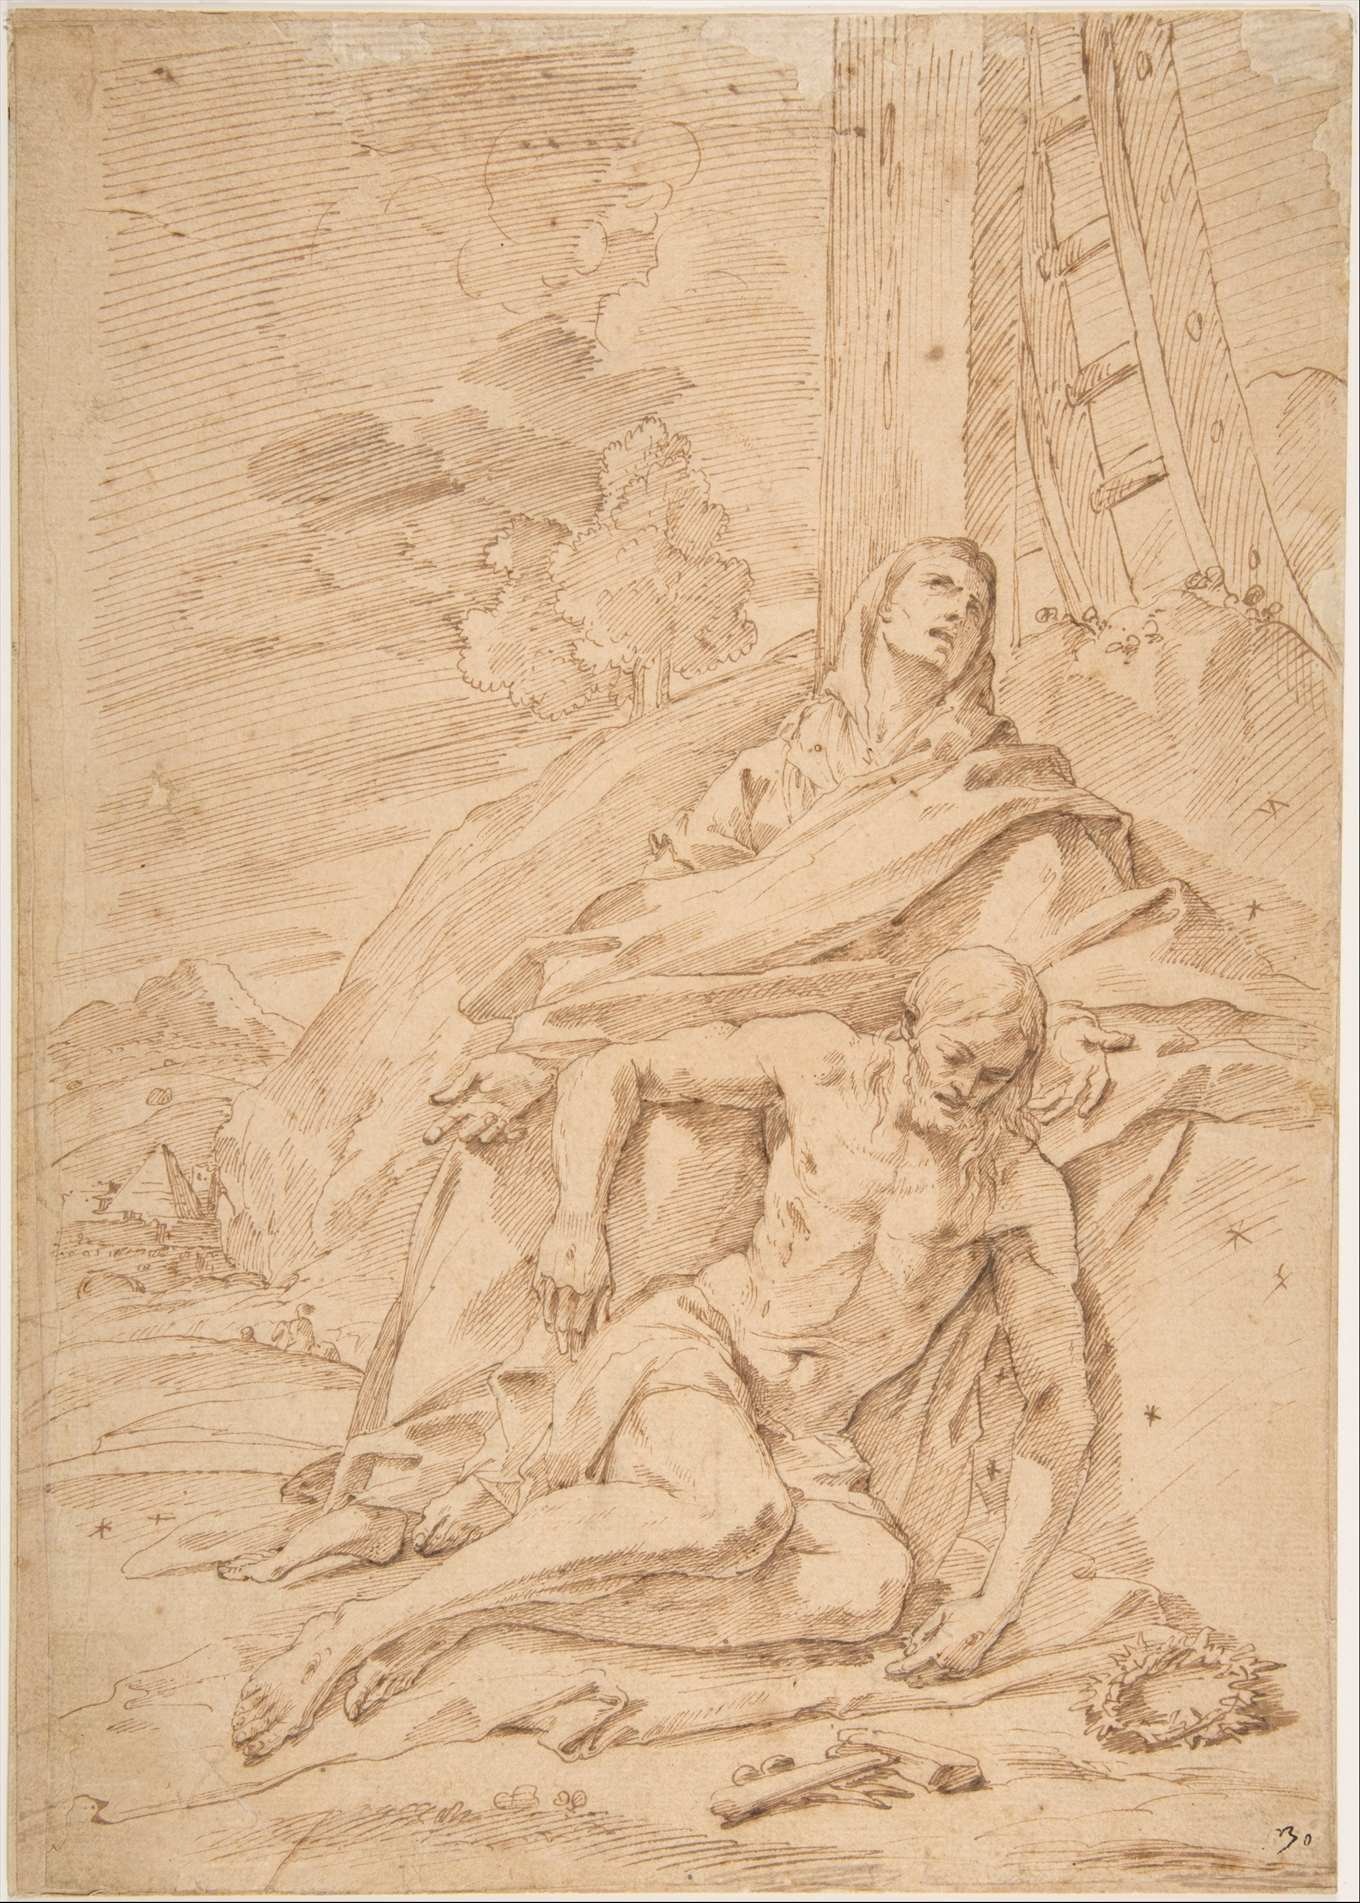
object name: drawing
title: The Virgin Lamenting over the Dead Christ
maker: pietro testa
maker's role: artist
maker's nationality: italian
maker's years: 1612-1650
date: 1612-1650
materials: ink, paper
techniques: pen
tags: christ,virgin mary,lamentation,death